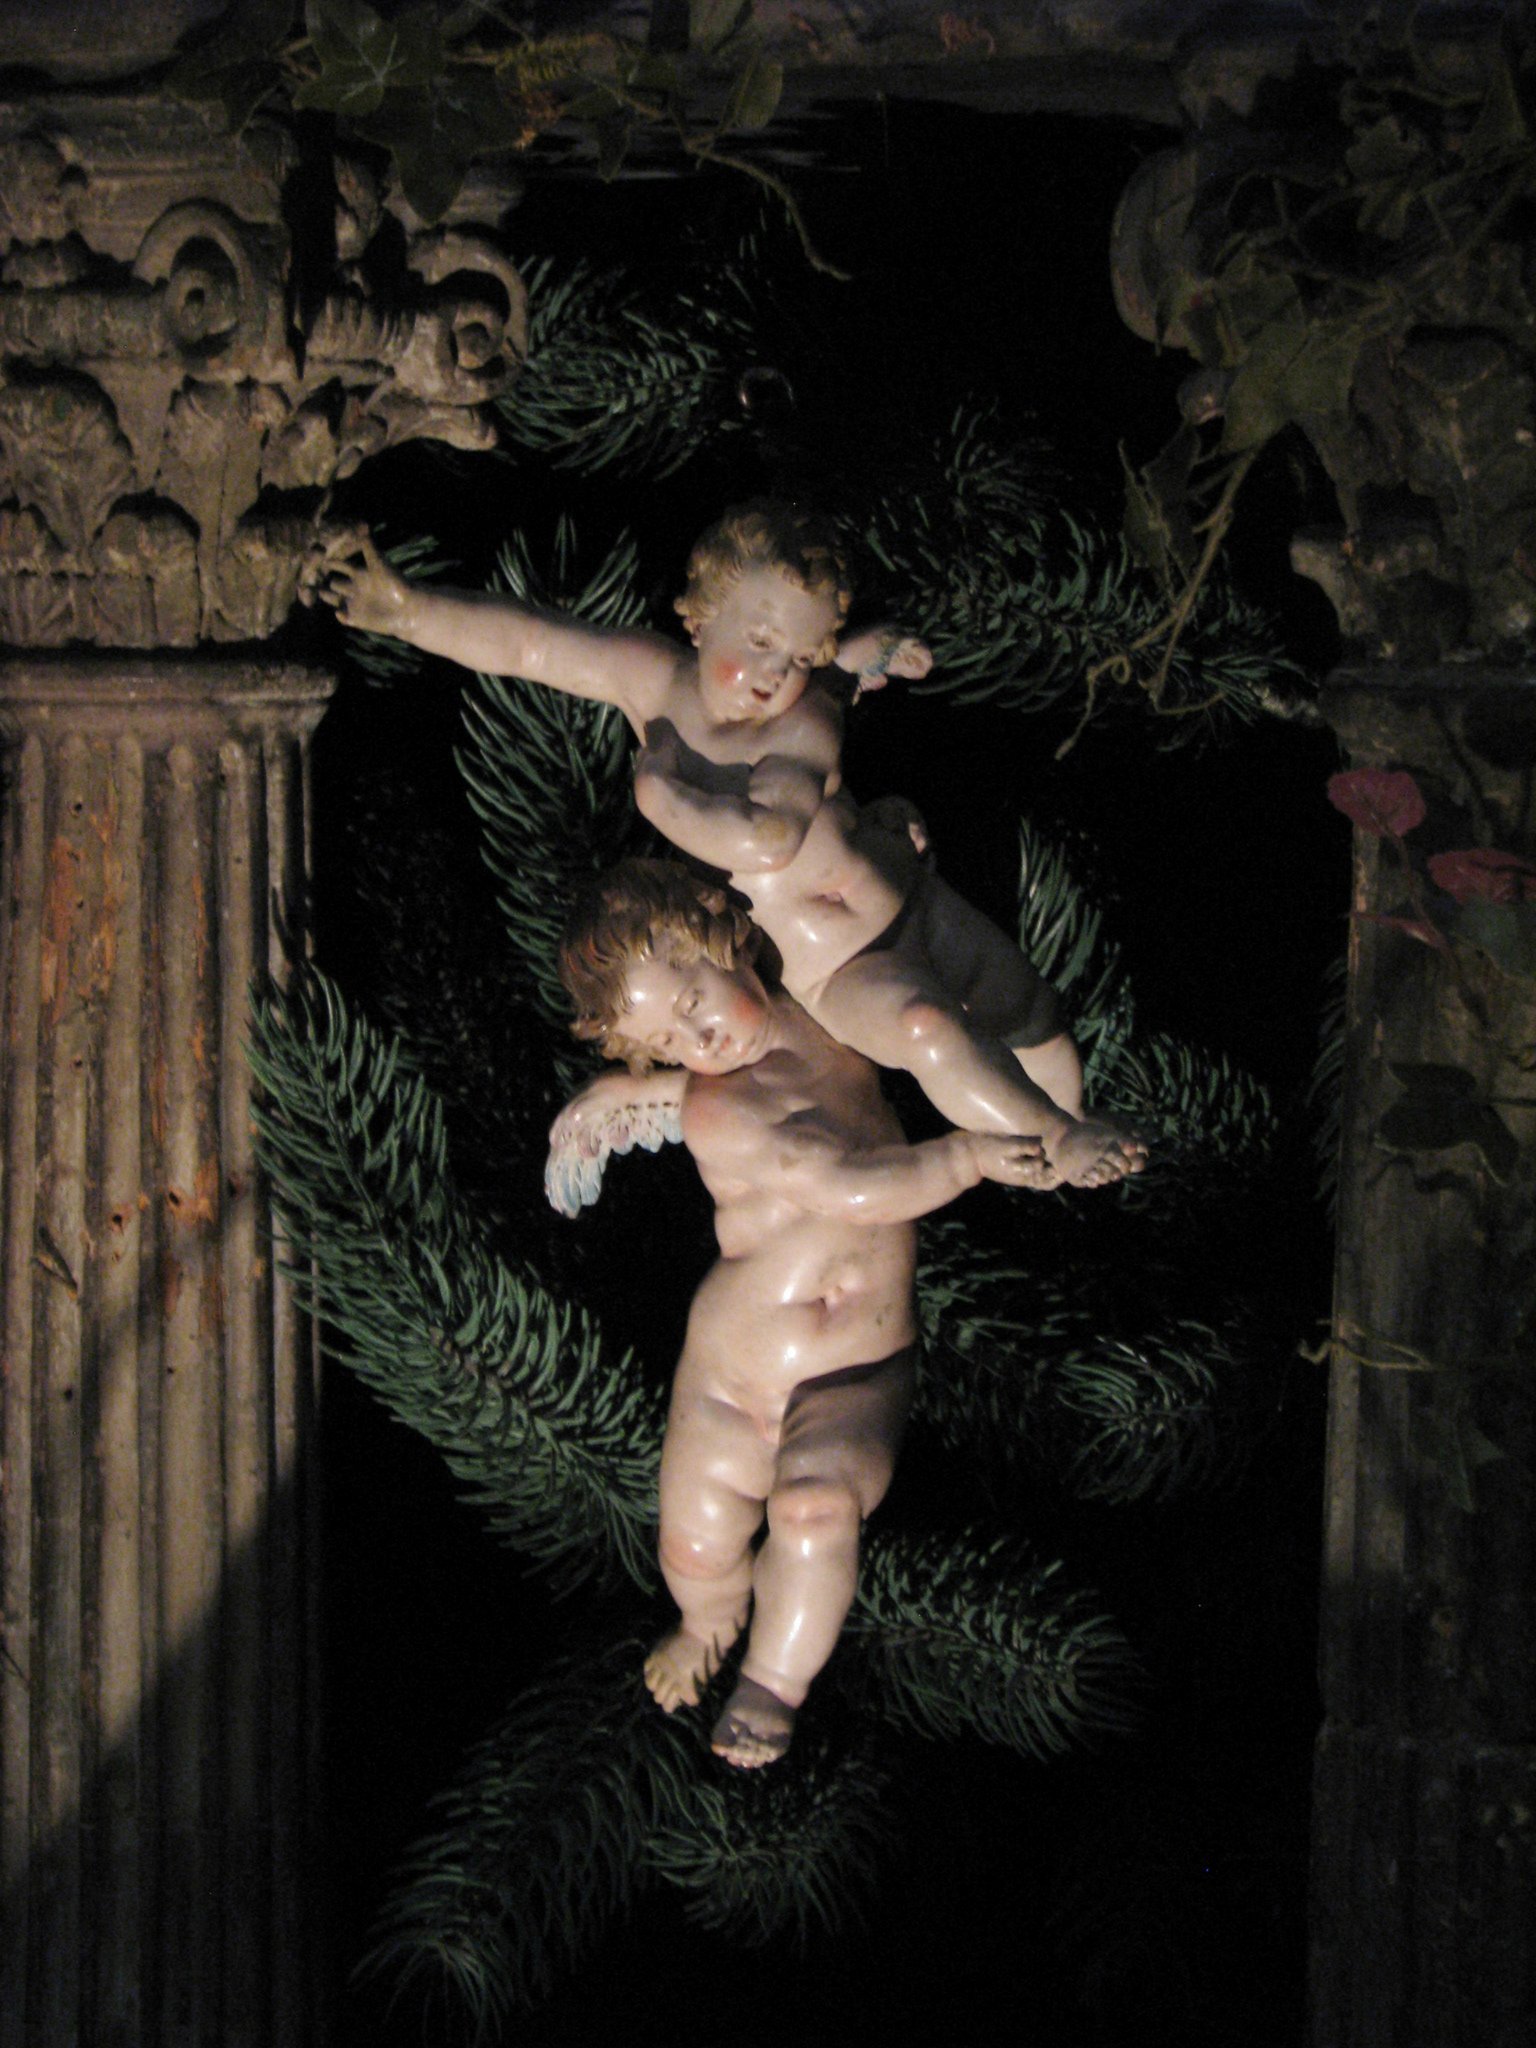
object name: crèche figure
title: Joined pair of cherubs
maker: giuseppe sanmartino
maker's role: maker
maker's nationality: italian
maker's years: 1720-1793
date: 1751-1800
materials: terracotta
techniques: polychrome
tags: angels